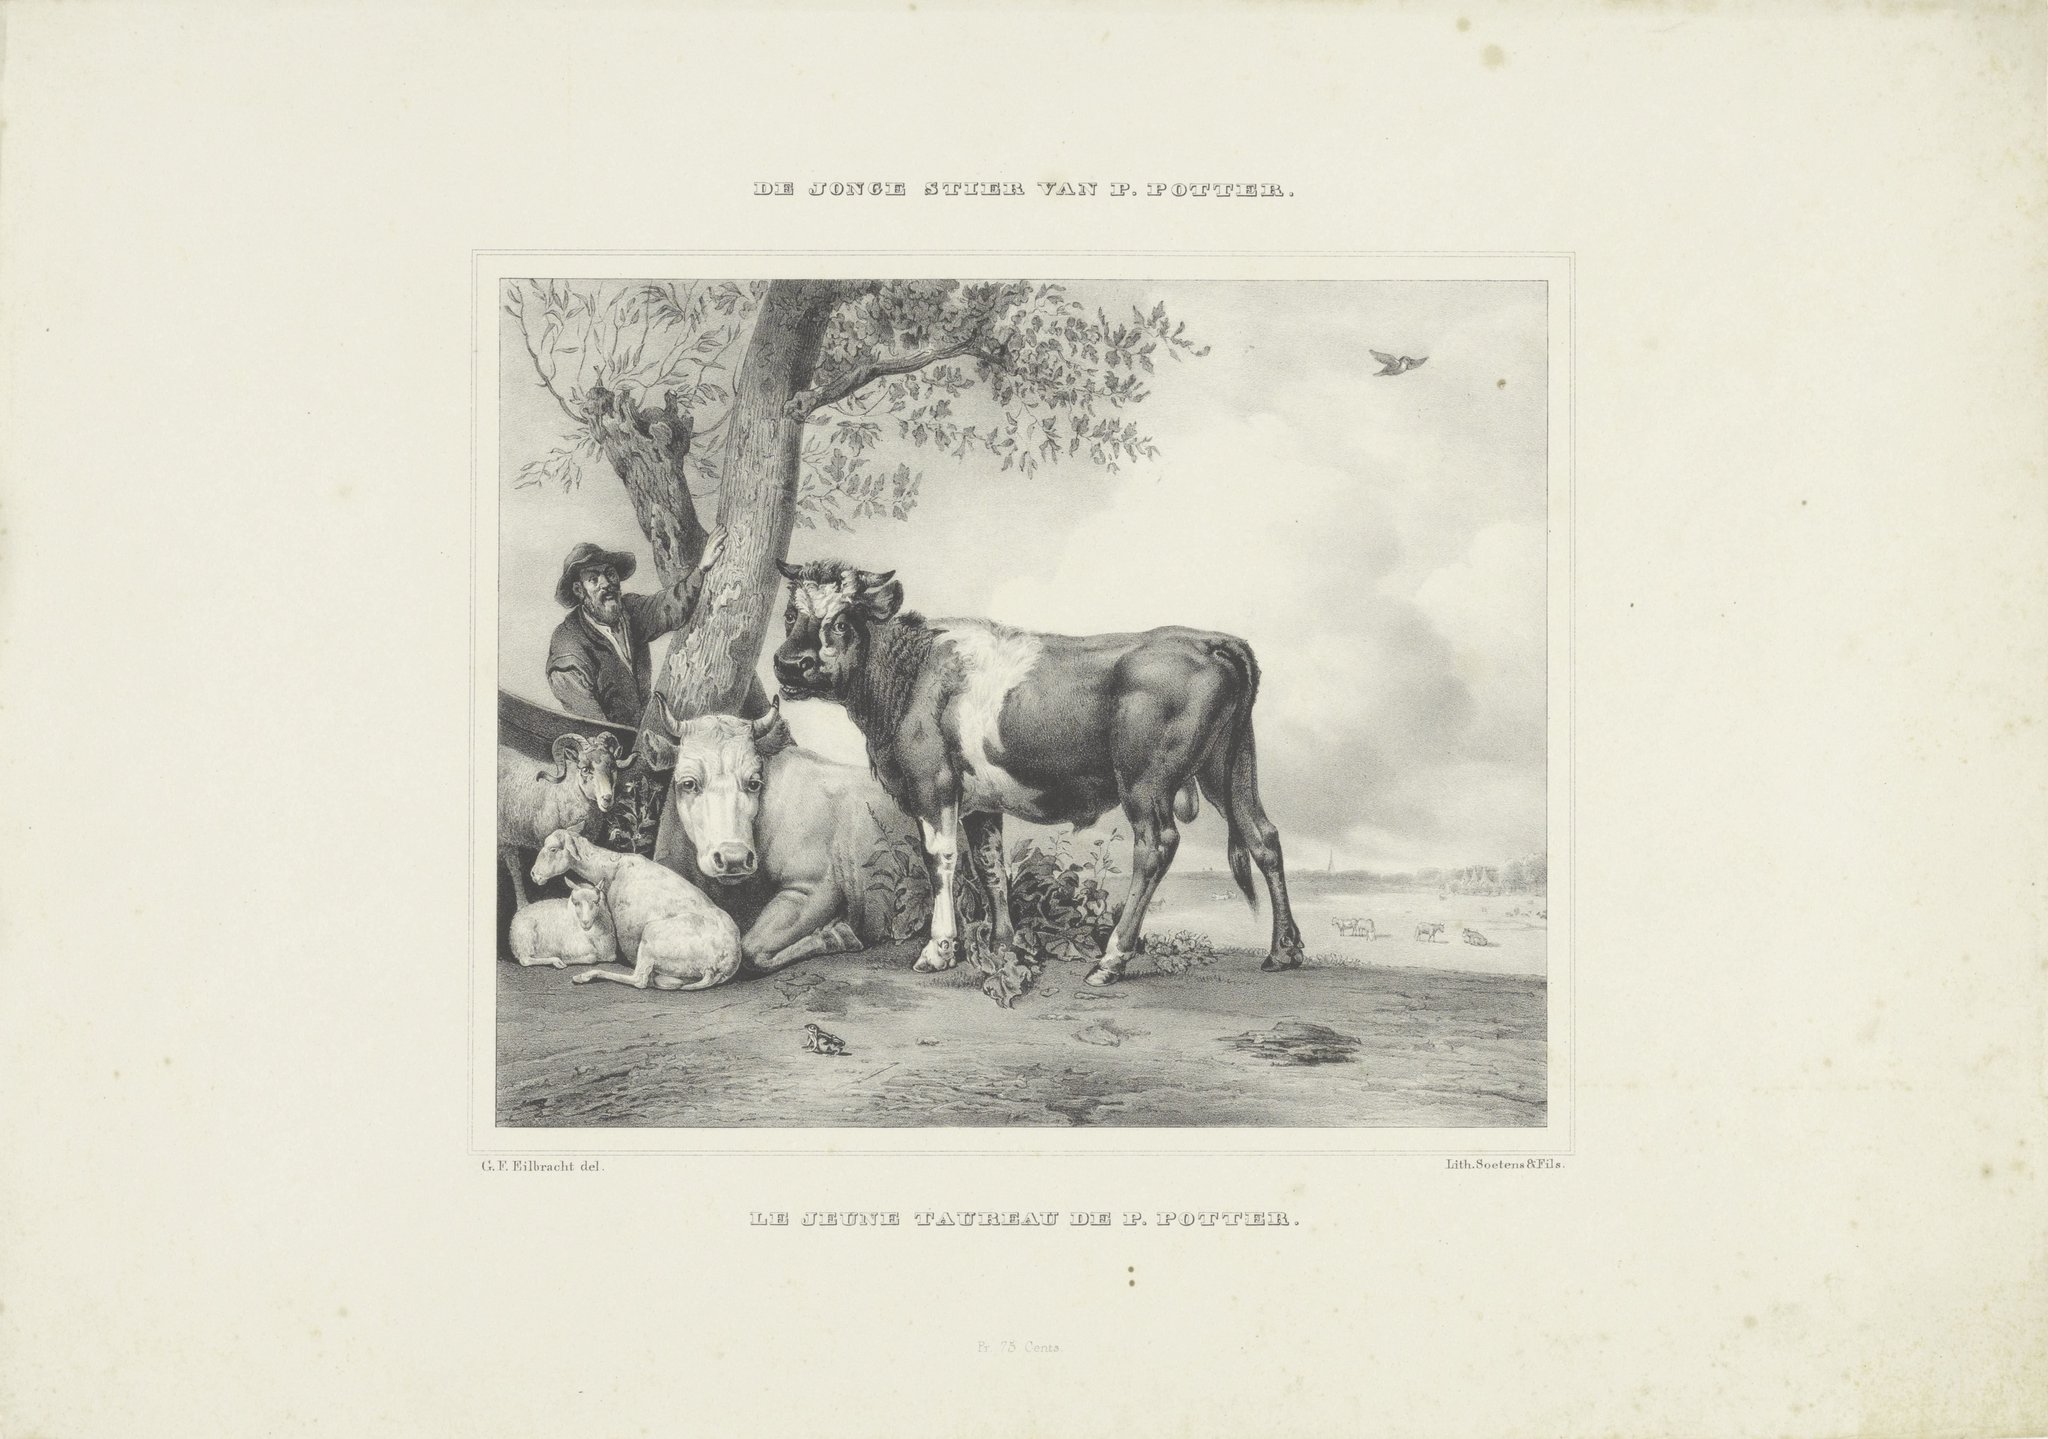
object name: print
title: De Jonge stier van P. Potter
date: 1837-1840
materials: paper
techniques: lithograph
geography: the hague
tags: bull, cow, sheep, song-birds: lark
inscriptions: collector's mark: Lugt 2233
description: In een landschap bij twee bomen staat een stier en ligt een koe. Daarnaast een schaap, een lam en een bok. Achter de bomen een man. Verderop een weiland met koeien. Op de voorgrond een kikker en in de lucht een vogel. Naar het schilderij van Paulus Potter in het Mauritshuis in Den Haag. Midden onder de prijs van de prent: 75 cents.